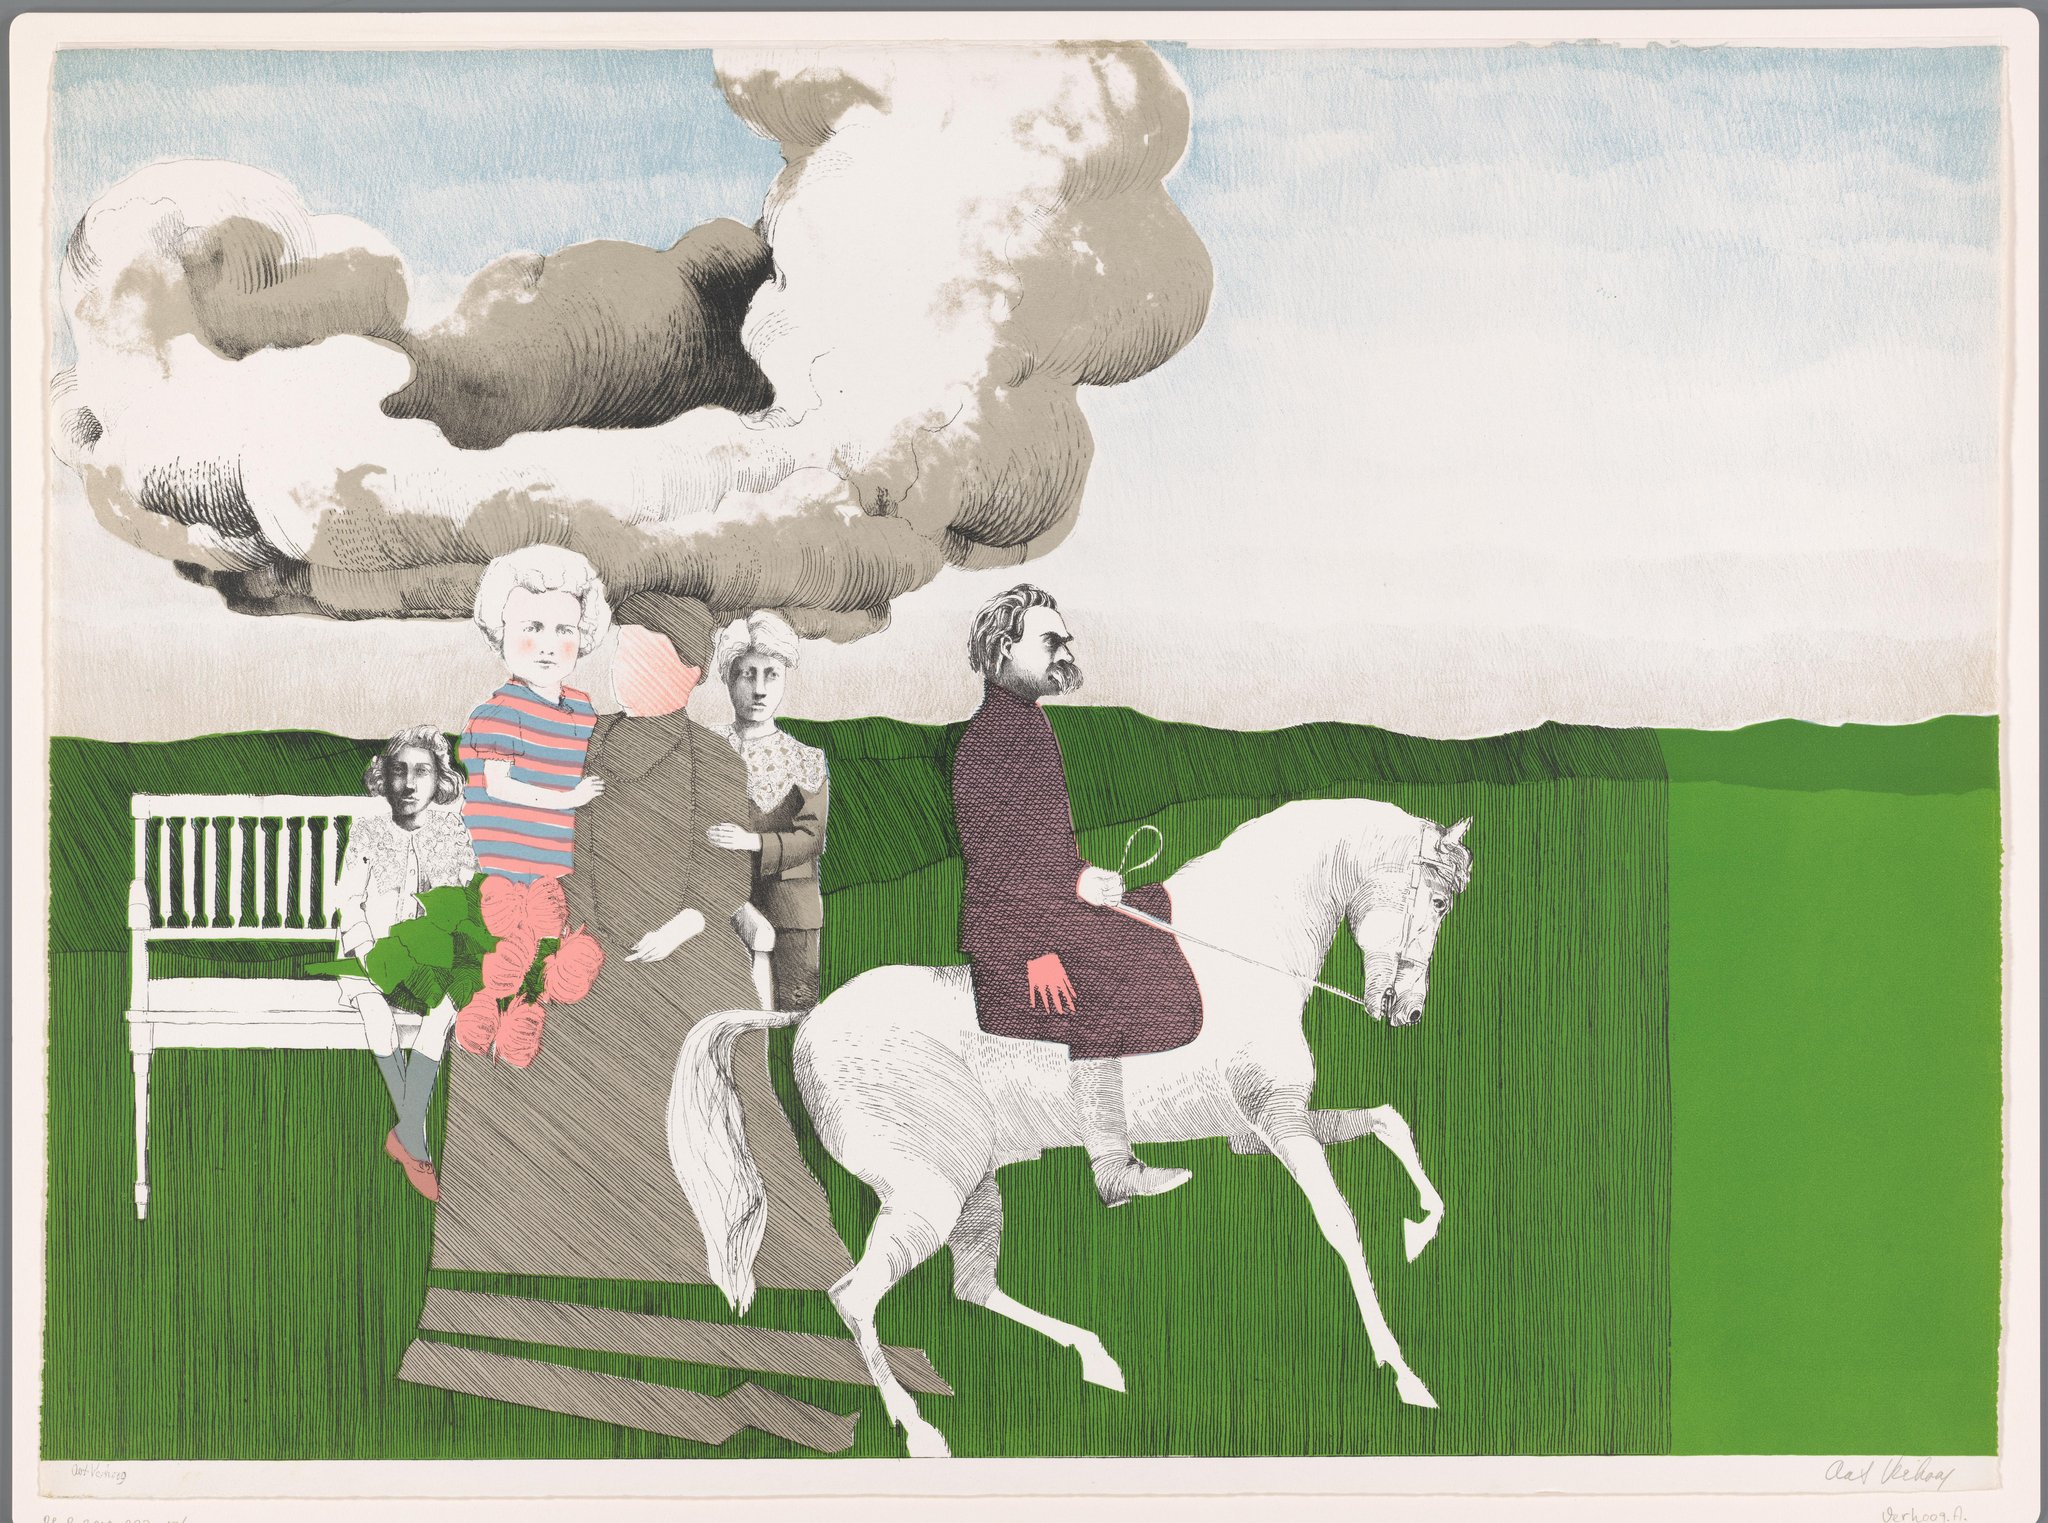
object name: print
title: Ruiter en meisje op bankje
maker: aat verhoog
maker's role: print maker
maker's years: 1933-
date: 1966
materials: paper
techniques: lithograph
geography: amsterdam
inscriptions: signature: ‘Aat Verhoog’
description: Ruiter (Nietzsche) rechts en meisje op bank links. Drie staande vrouwen vóór de bank.